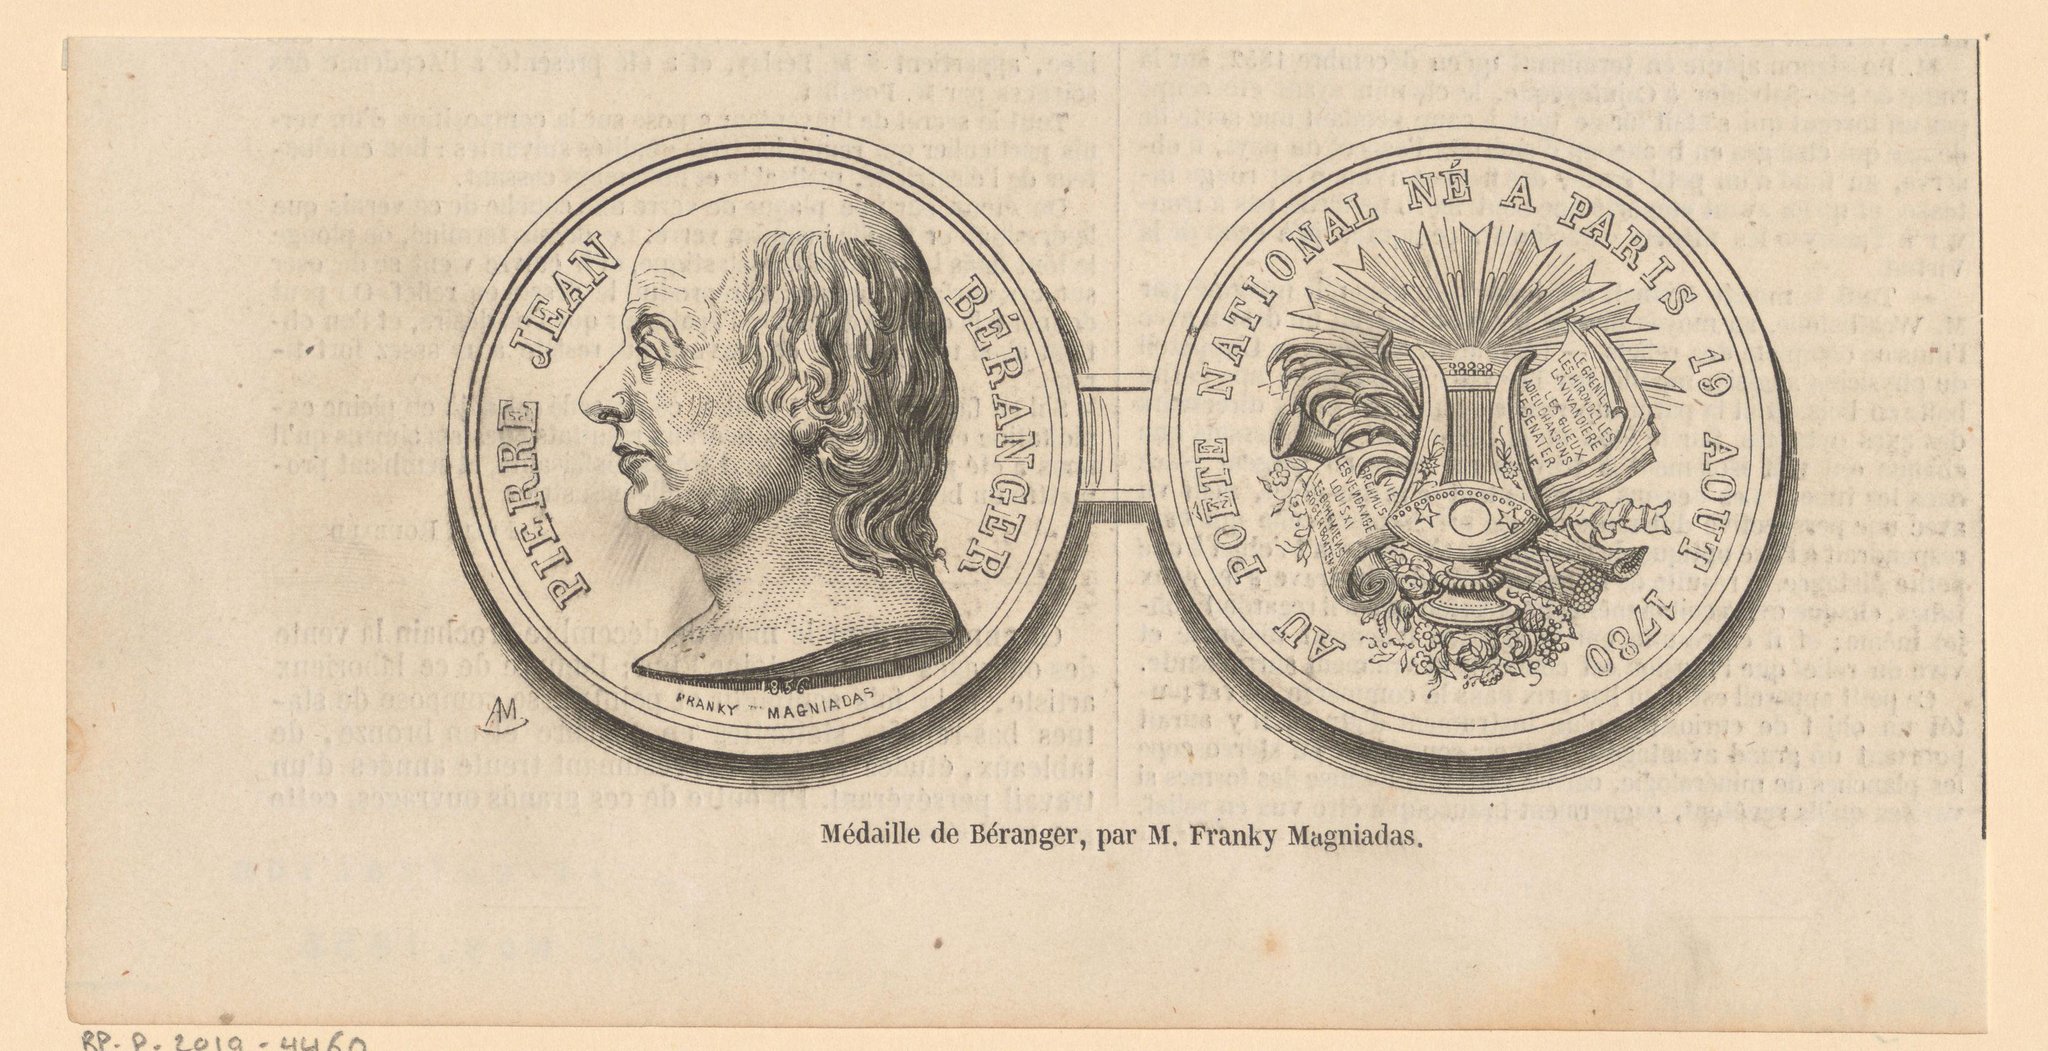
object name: print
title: Penning met een portret van Pierre-Jean de Béranger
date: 1856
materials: paper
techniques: letterpress printing, engraving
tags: paris, pierre-jean de béranger, historical persons, writer, poet, author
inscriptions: inscription: ‘L'Illustration 22 Nov, 1856’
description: Prent uit: L'Illustration, journal universel, no. 717, 22 november 1856.